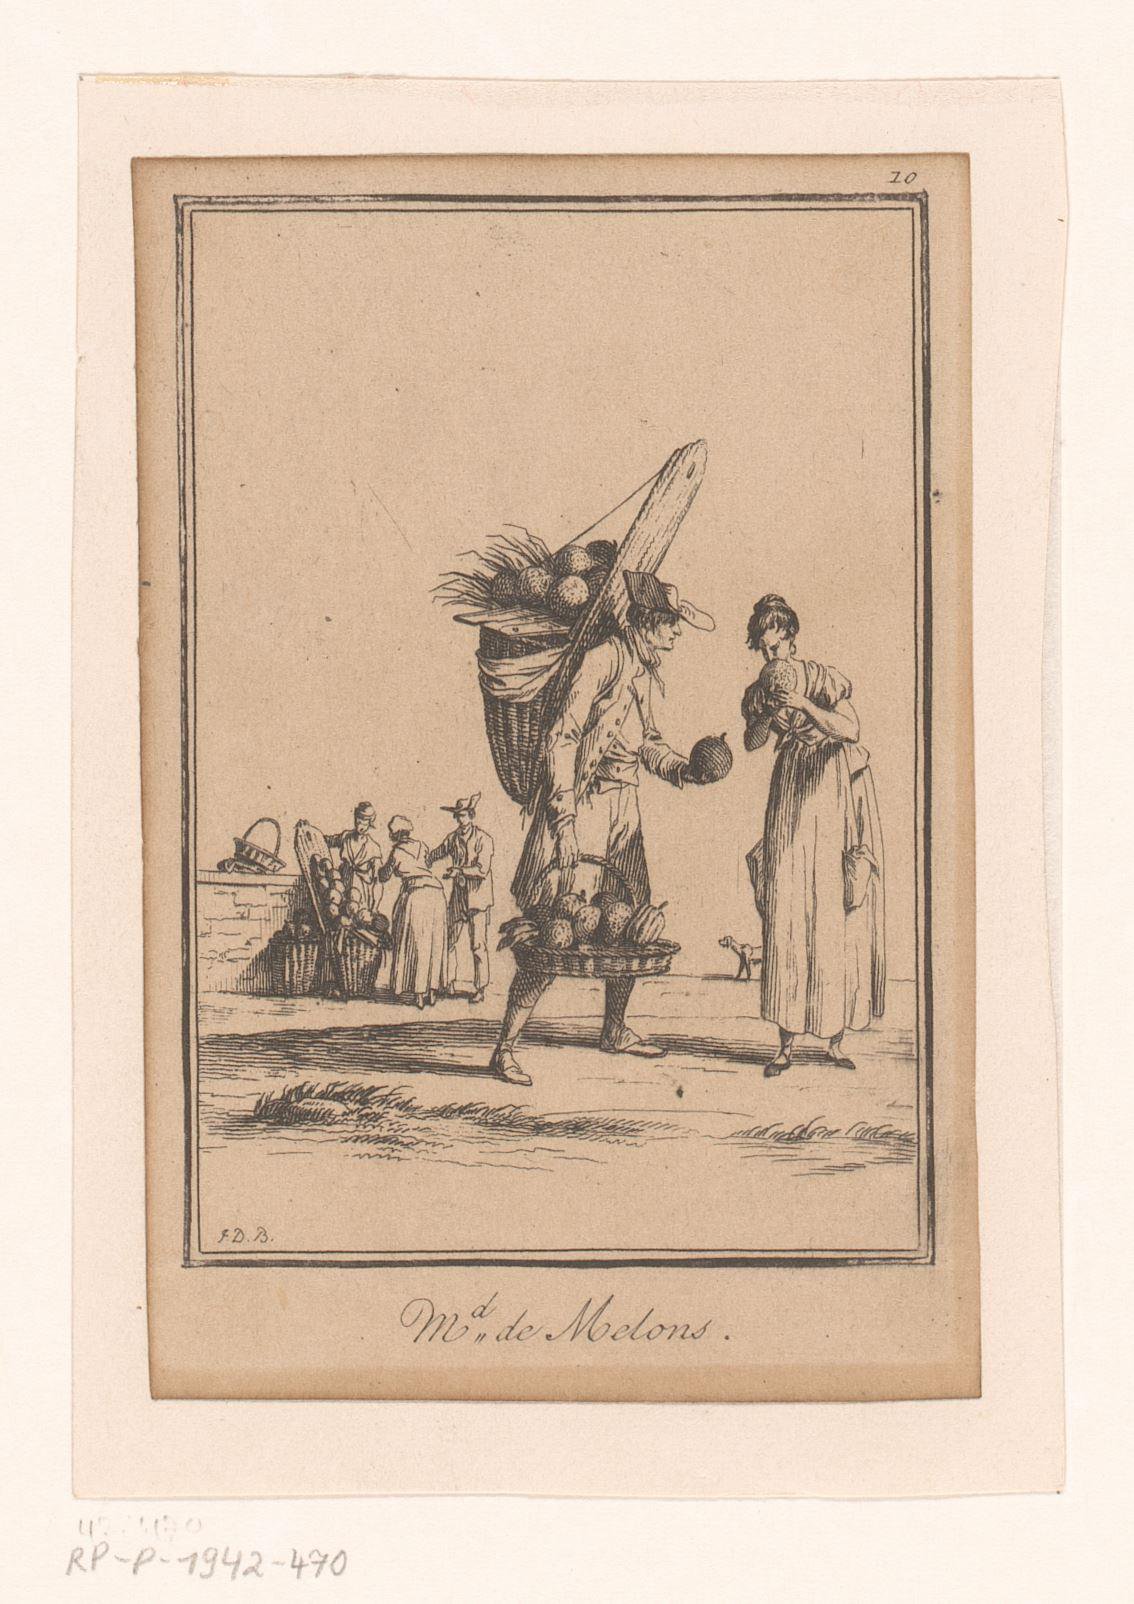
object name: print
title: Meloenenverkoper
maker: jean duplessis-bertaux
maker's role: print maker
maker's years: 1750-1818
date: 1760-1818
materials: paper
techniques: etching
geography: france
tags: fruits: melon, 'cris de paris', cries of london, etc.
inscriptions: collector's mark: Lugt 2228